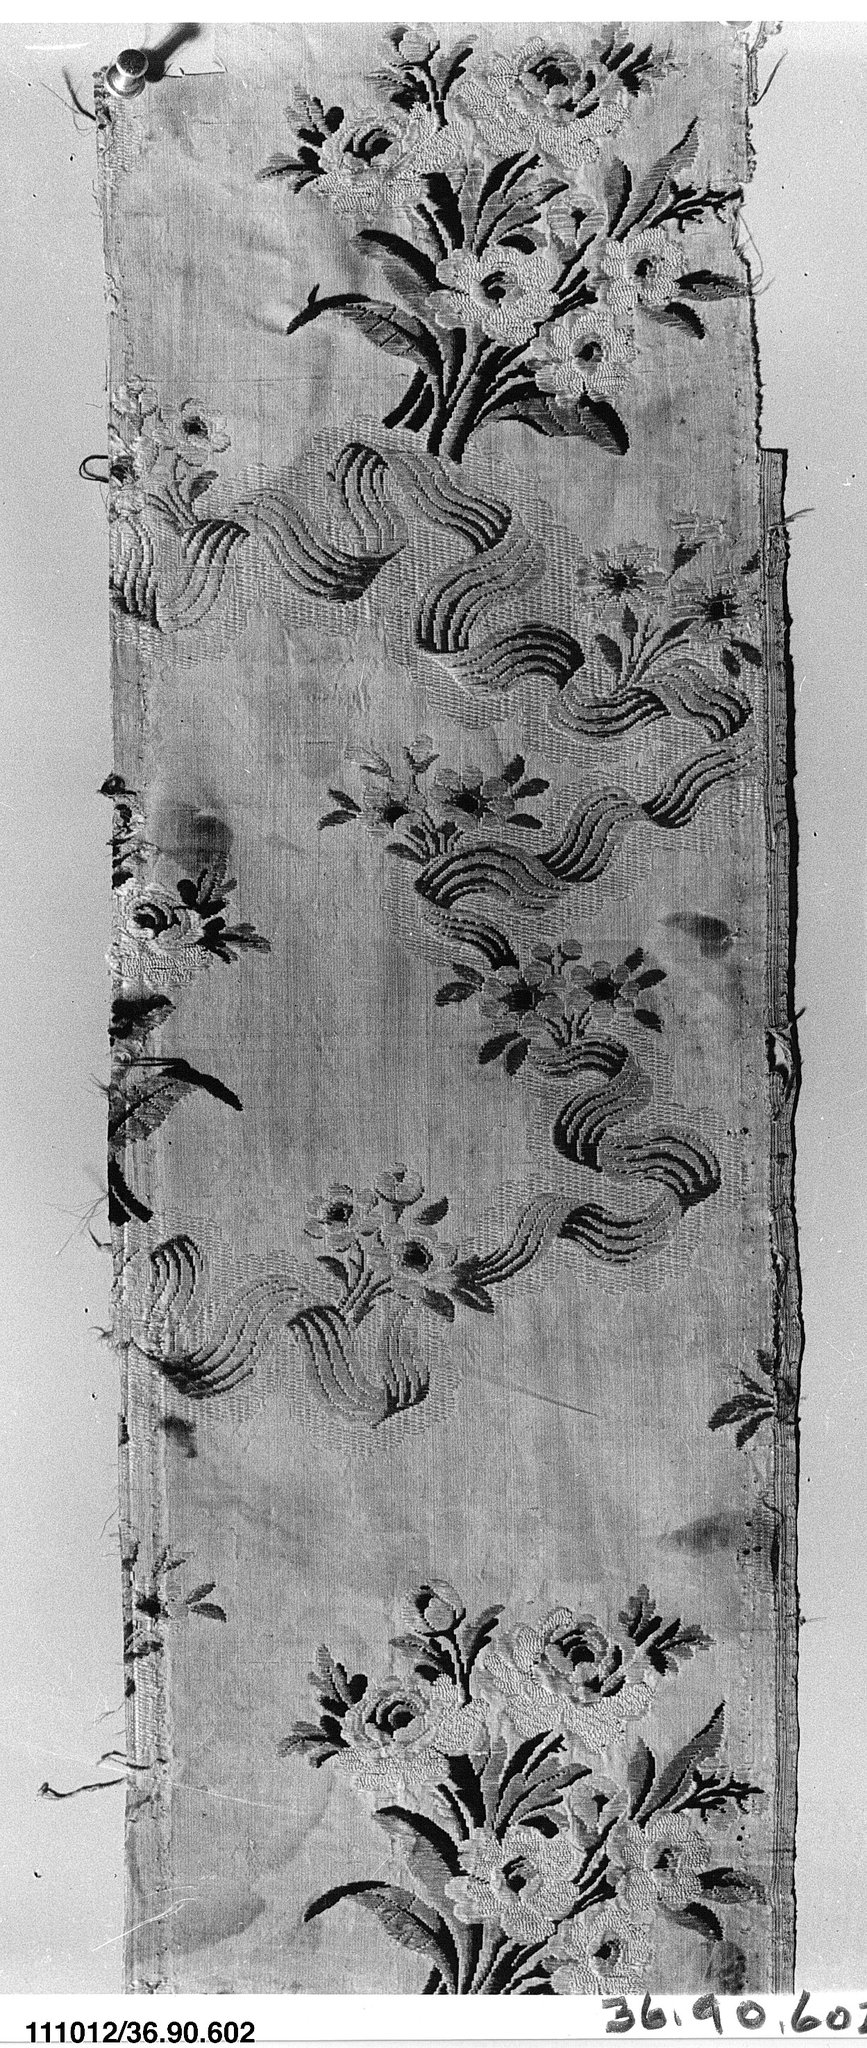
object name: piece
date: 1734-1766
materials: silk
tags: flowers